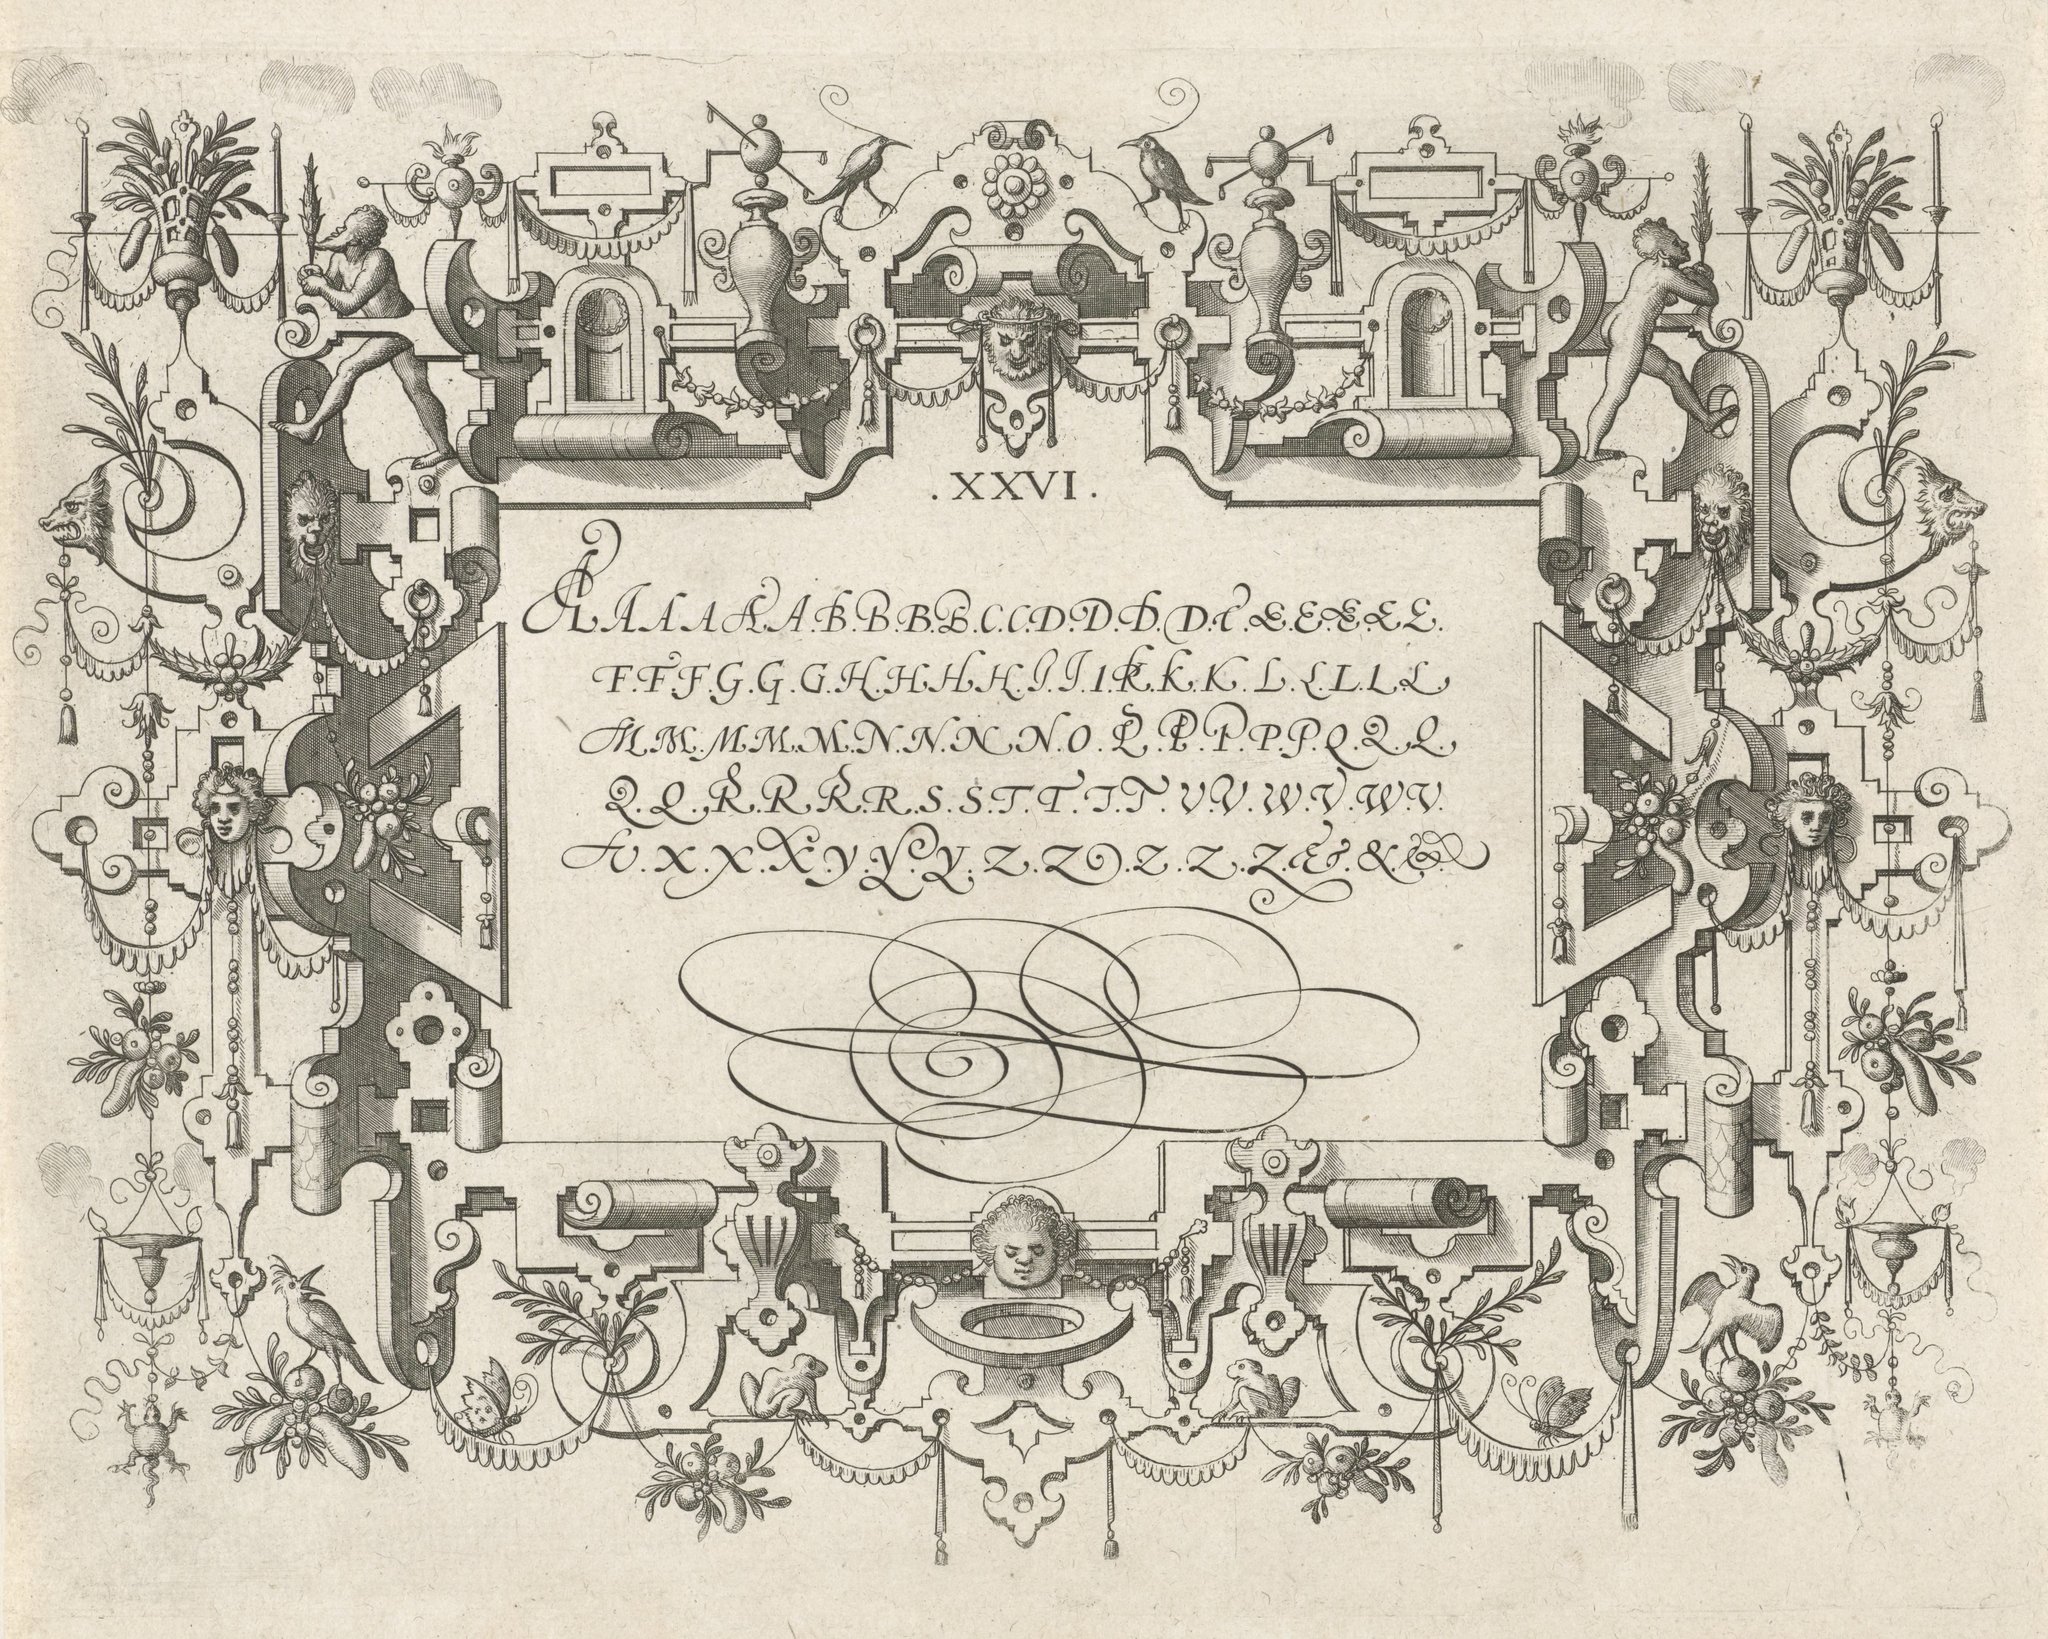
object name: ornament print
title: Cartouche met aan beide zijde een mascaron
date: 1569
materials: paper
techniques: etching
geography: netherlands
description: Blad XXVI. Uit serie van 21 genummerde cartouches met kalligrafie in een omlijsting van rol- en beslagwerk met grotesken, guirlandes en mascarons .